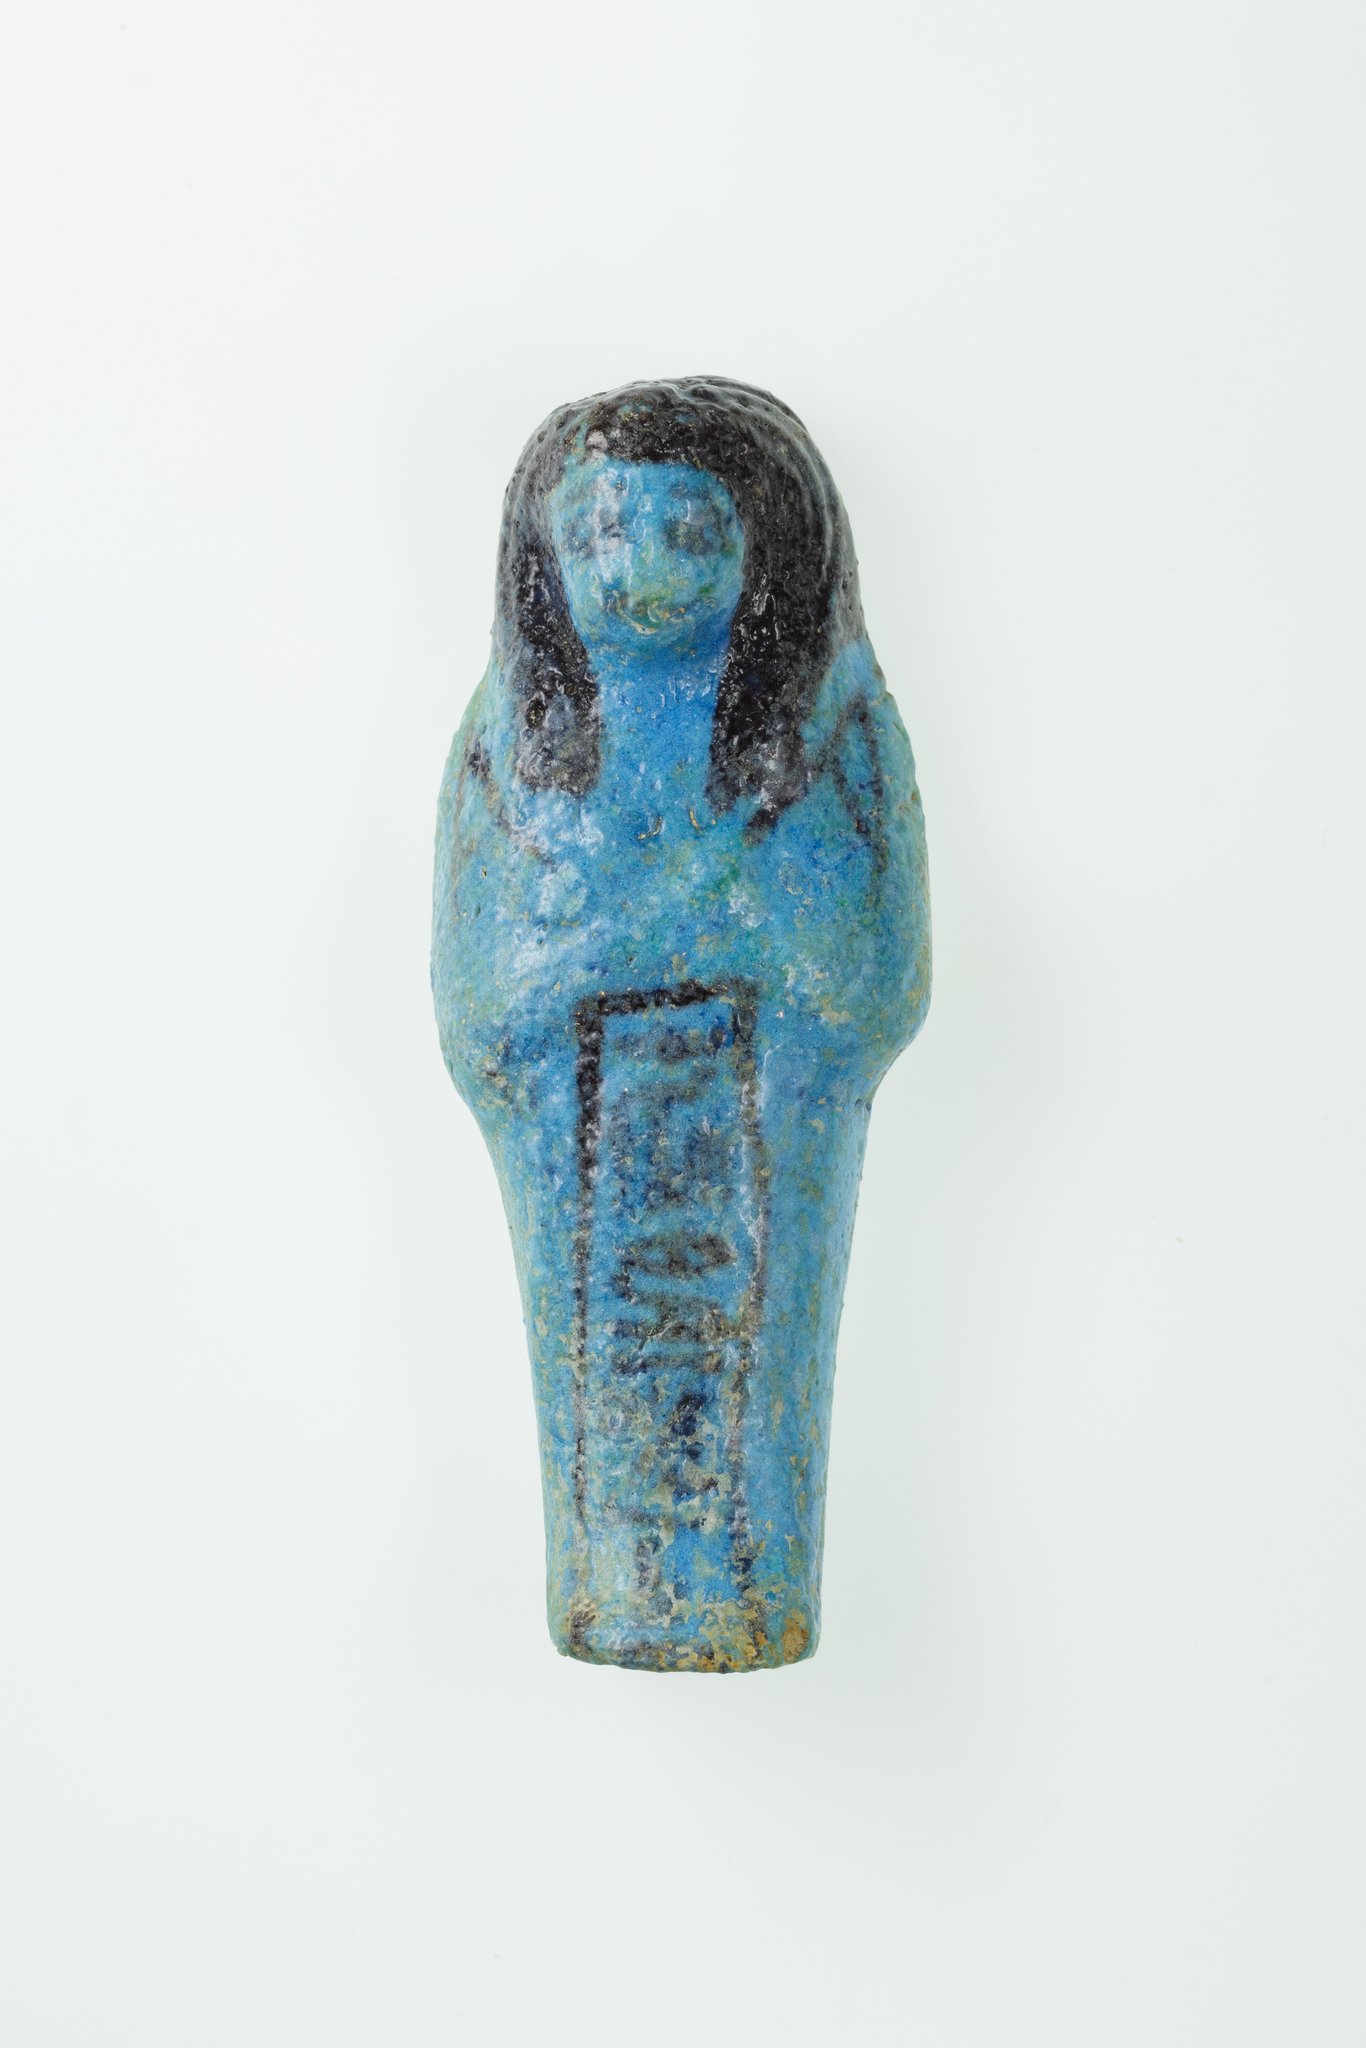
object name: shabti, worker, nauny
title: Worker Shabti of Nauny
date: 1050 BCE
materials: faience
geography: egypt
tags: hieroglyphs